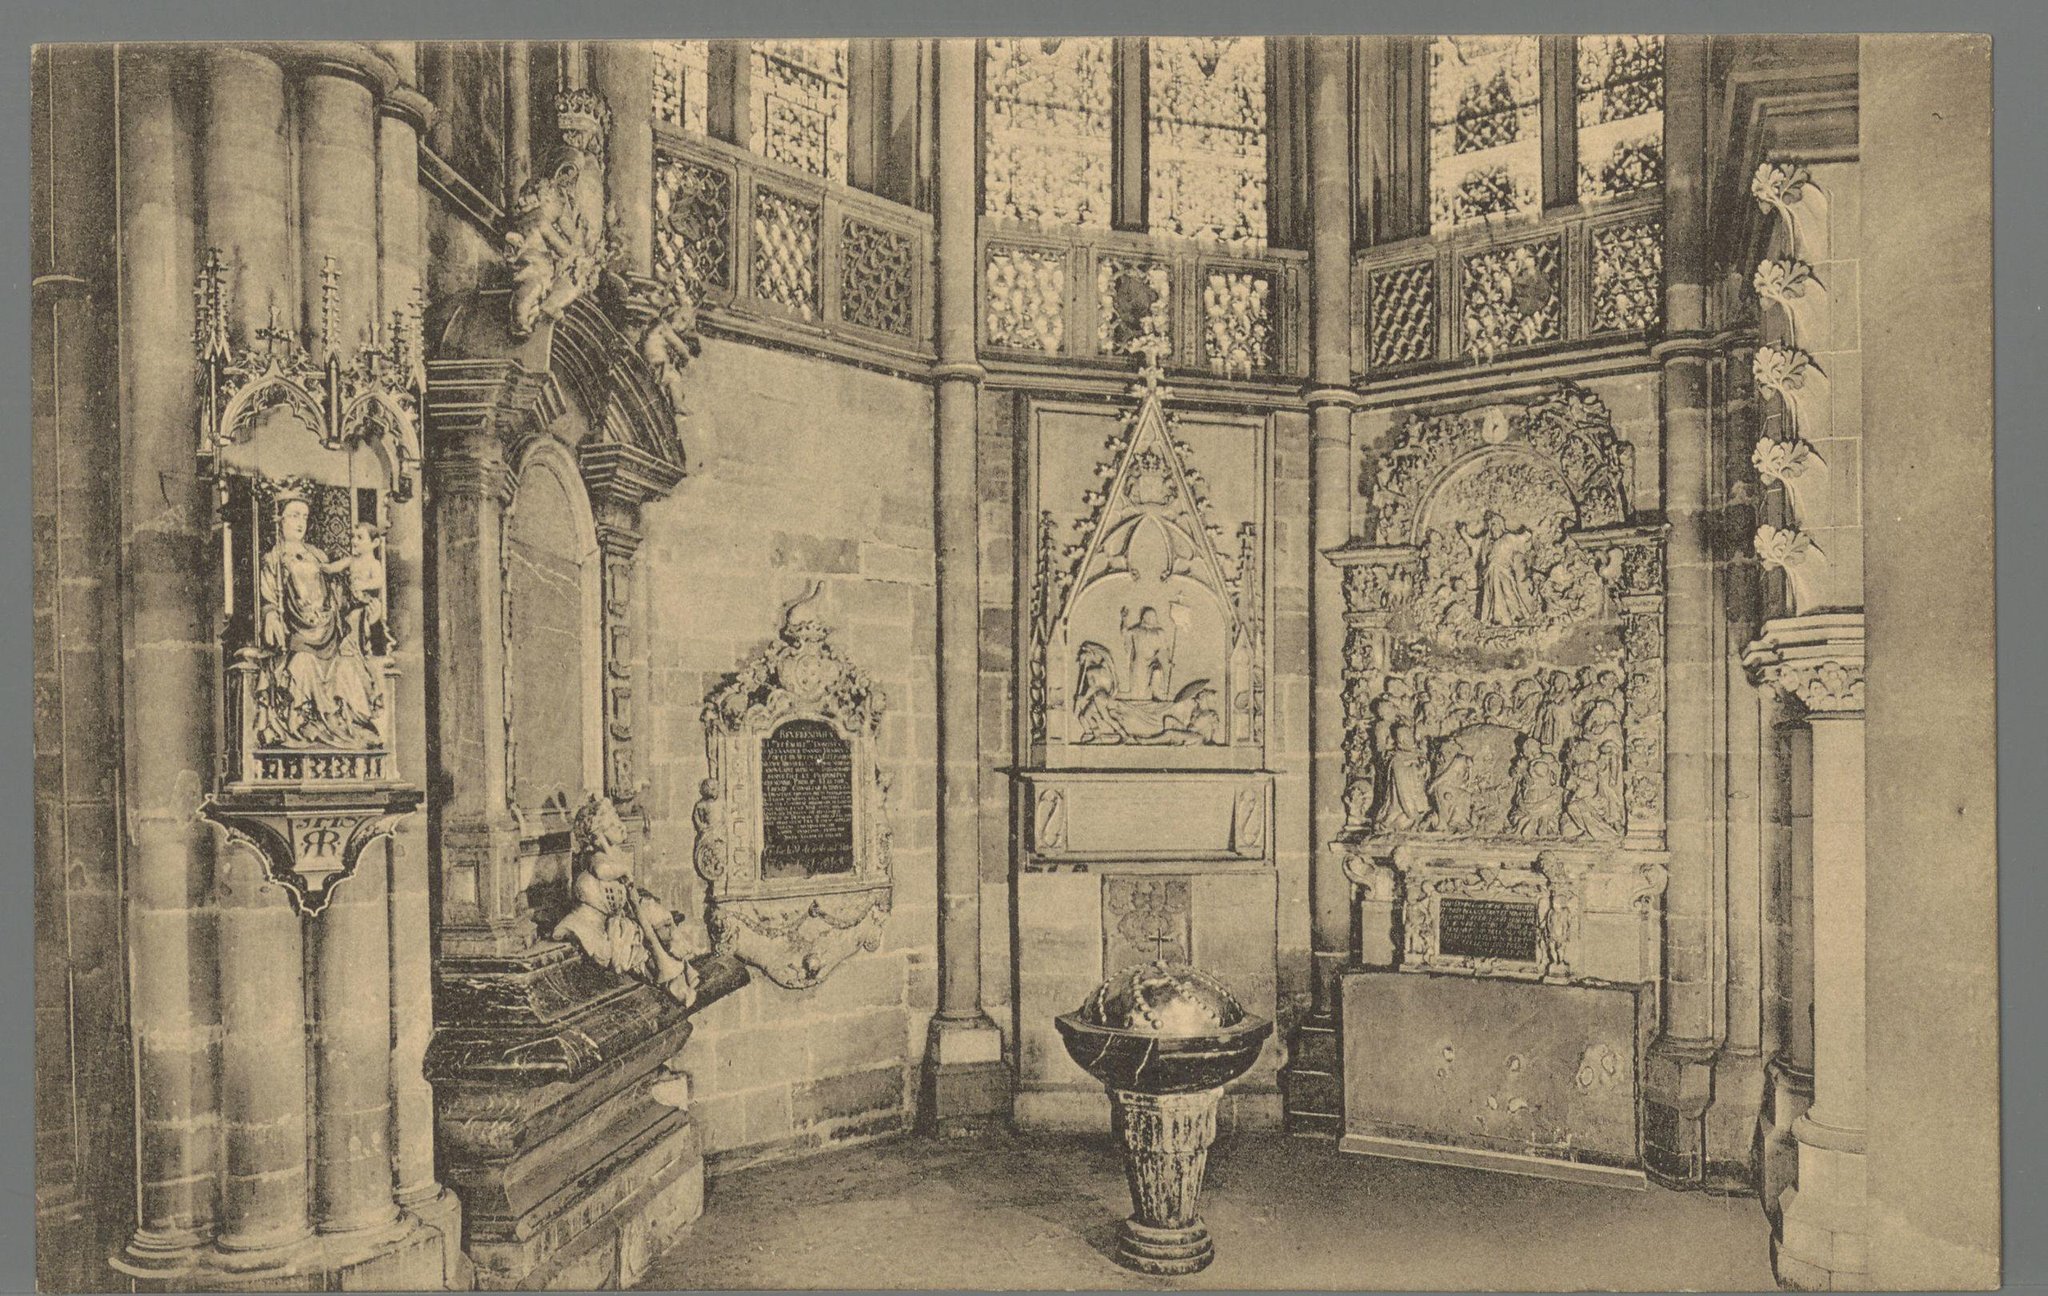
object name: photomechanical print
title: Trier. Liebfrauenkirche. Grabmäler und Taufstein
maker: Anonymous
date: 1905-1930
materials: cardboard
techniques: photograph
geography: trier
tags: grave, tomb, interior of church